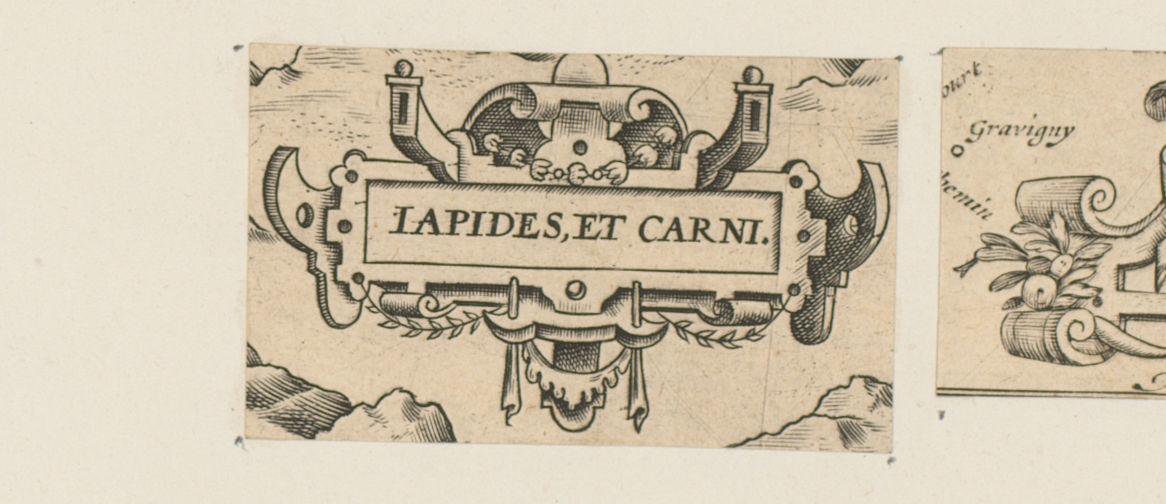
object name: album leaf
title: Theatrum Orbis Terrarum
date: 1573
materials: paper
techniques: engraving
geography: antwerp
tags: scrollwork, strapwork ~ ornament, ornament ~ cartouche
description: Kleine cartouche met bladranken en midden onder een slinger. De cartouche is een fragment van een kaart van Friuli. De prent maakt deel uit van een album.